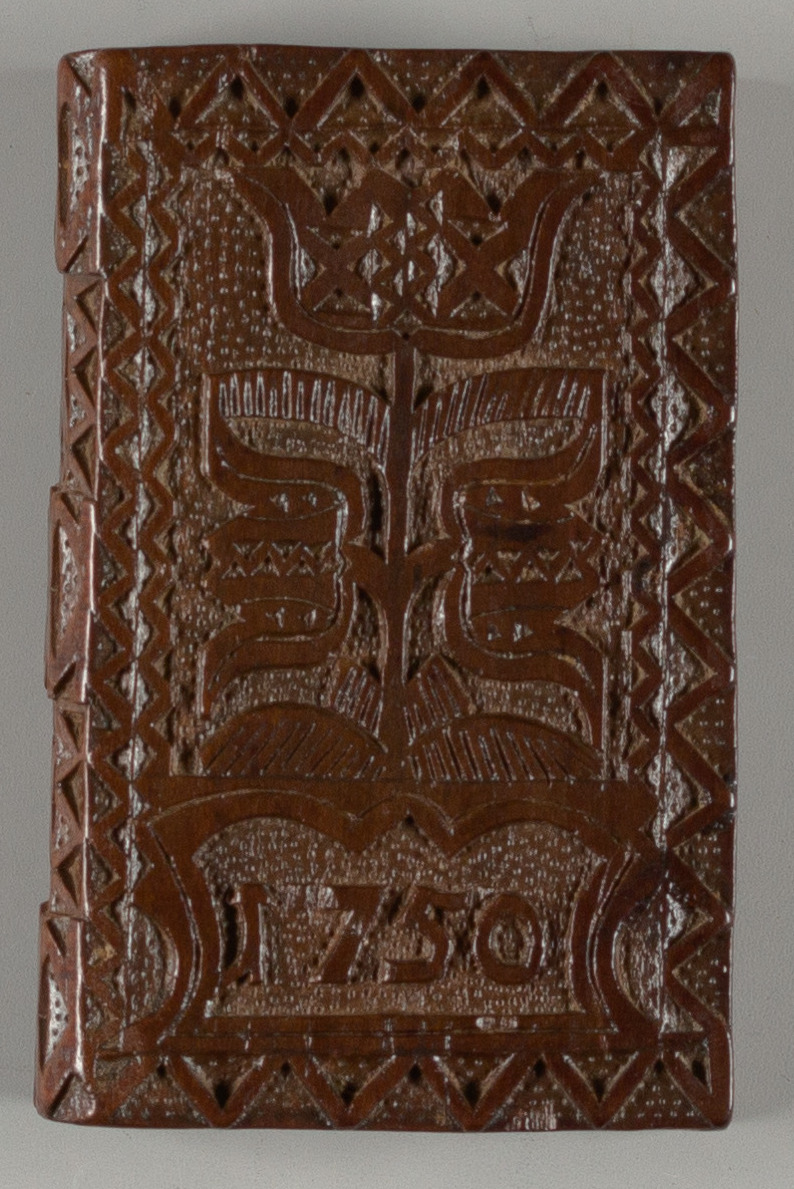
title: Box with tulip motif in book form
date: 1750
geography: europe